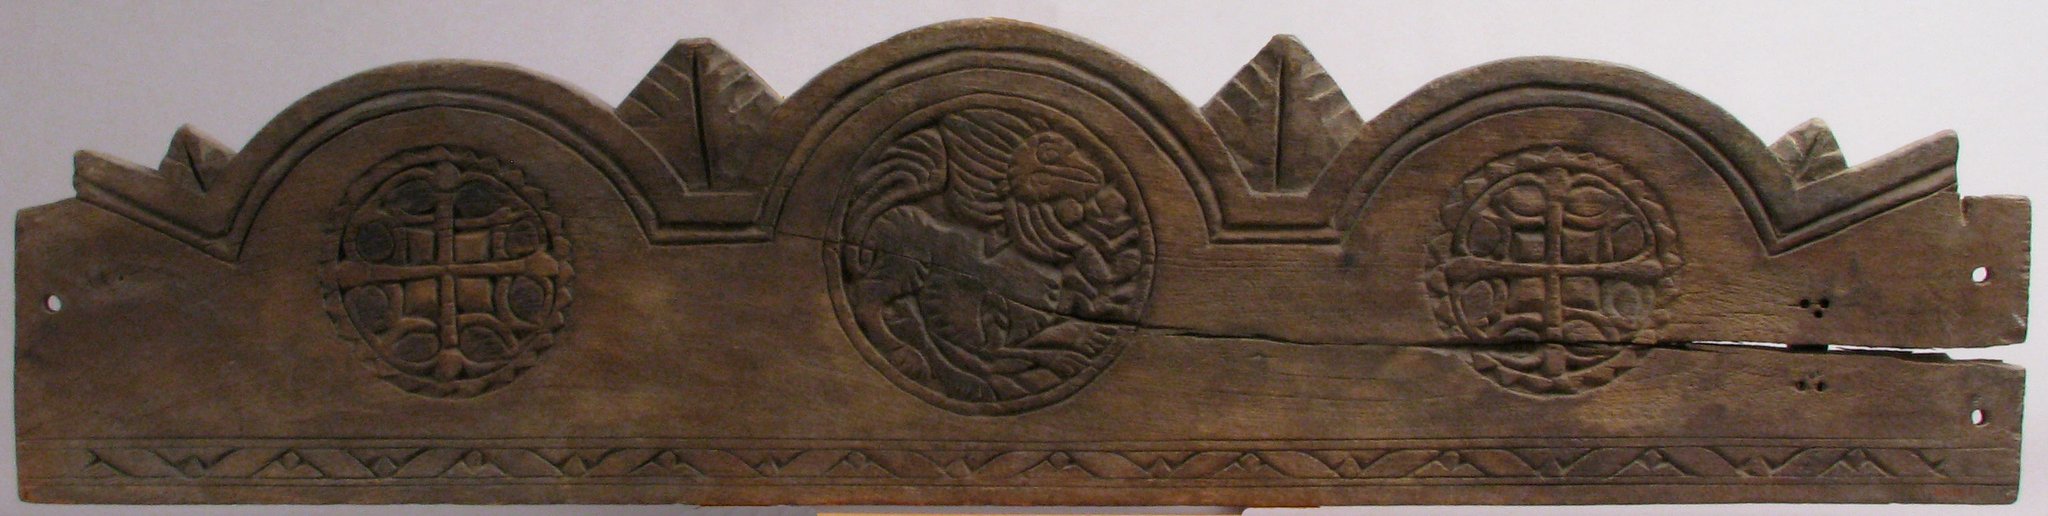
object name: panel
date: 501-700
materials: wood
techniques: carving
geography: egypt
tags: lions,cross